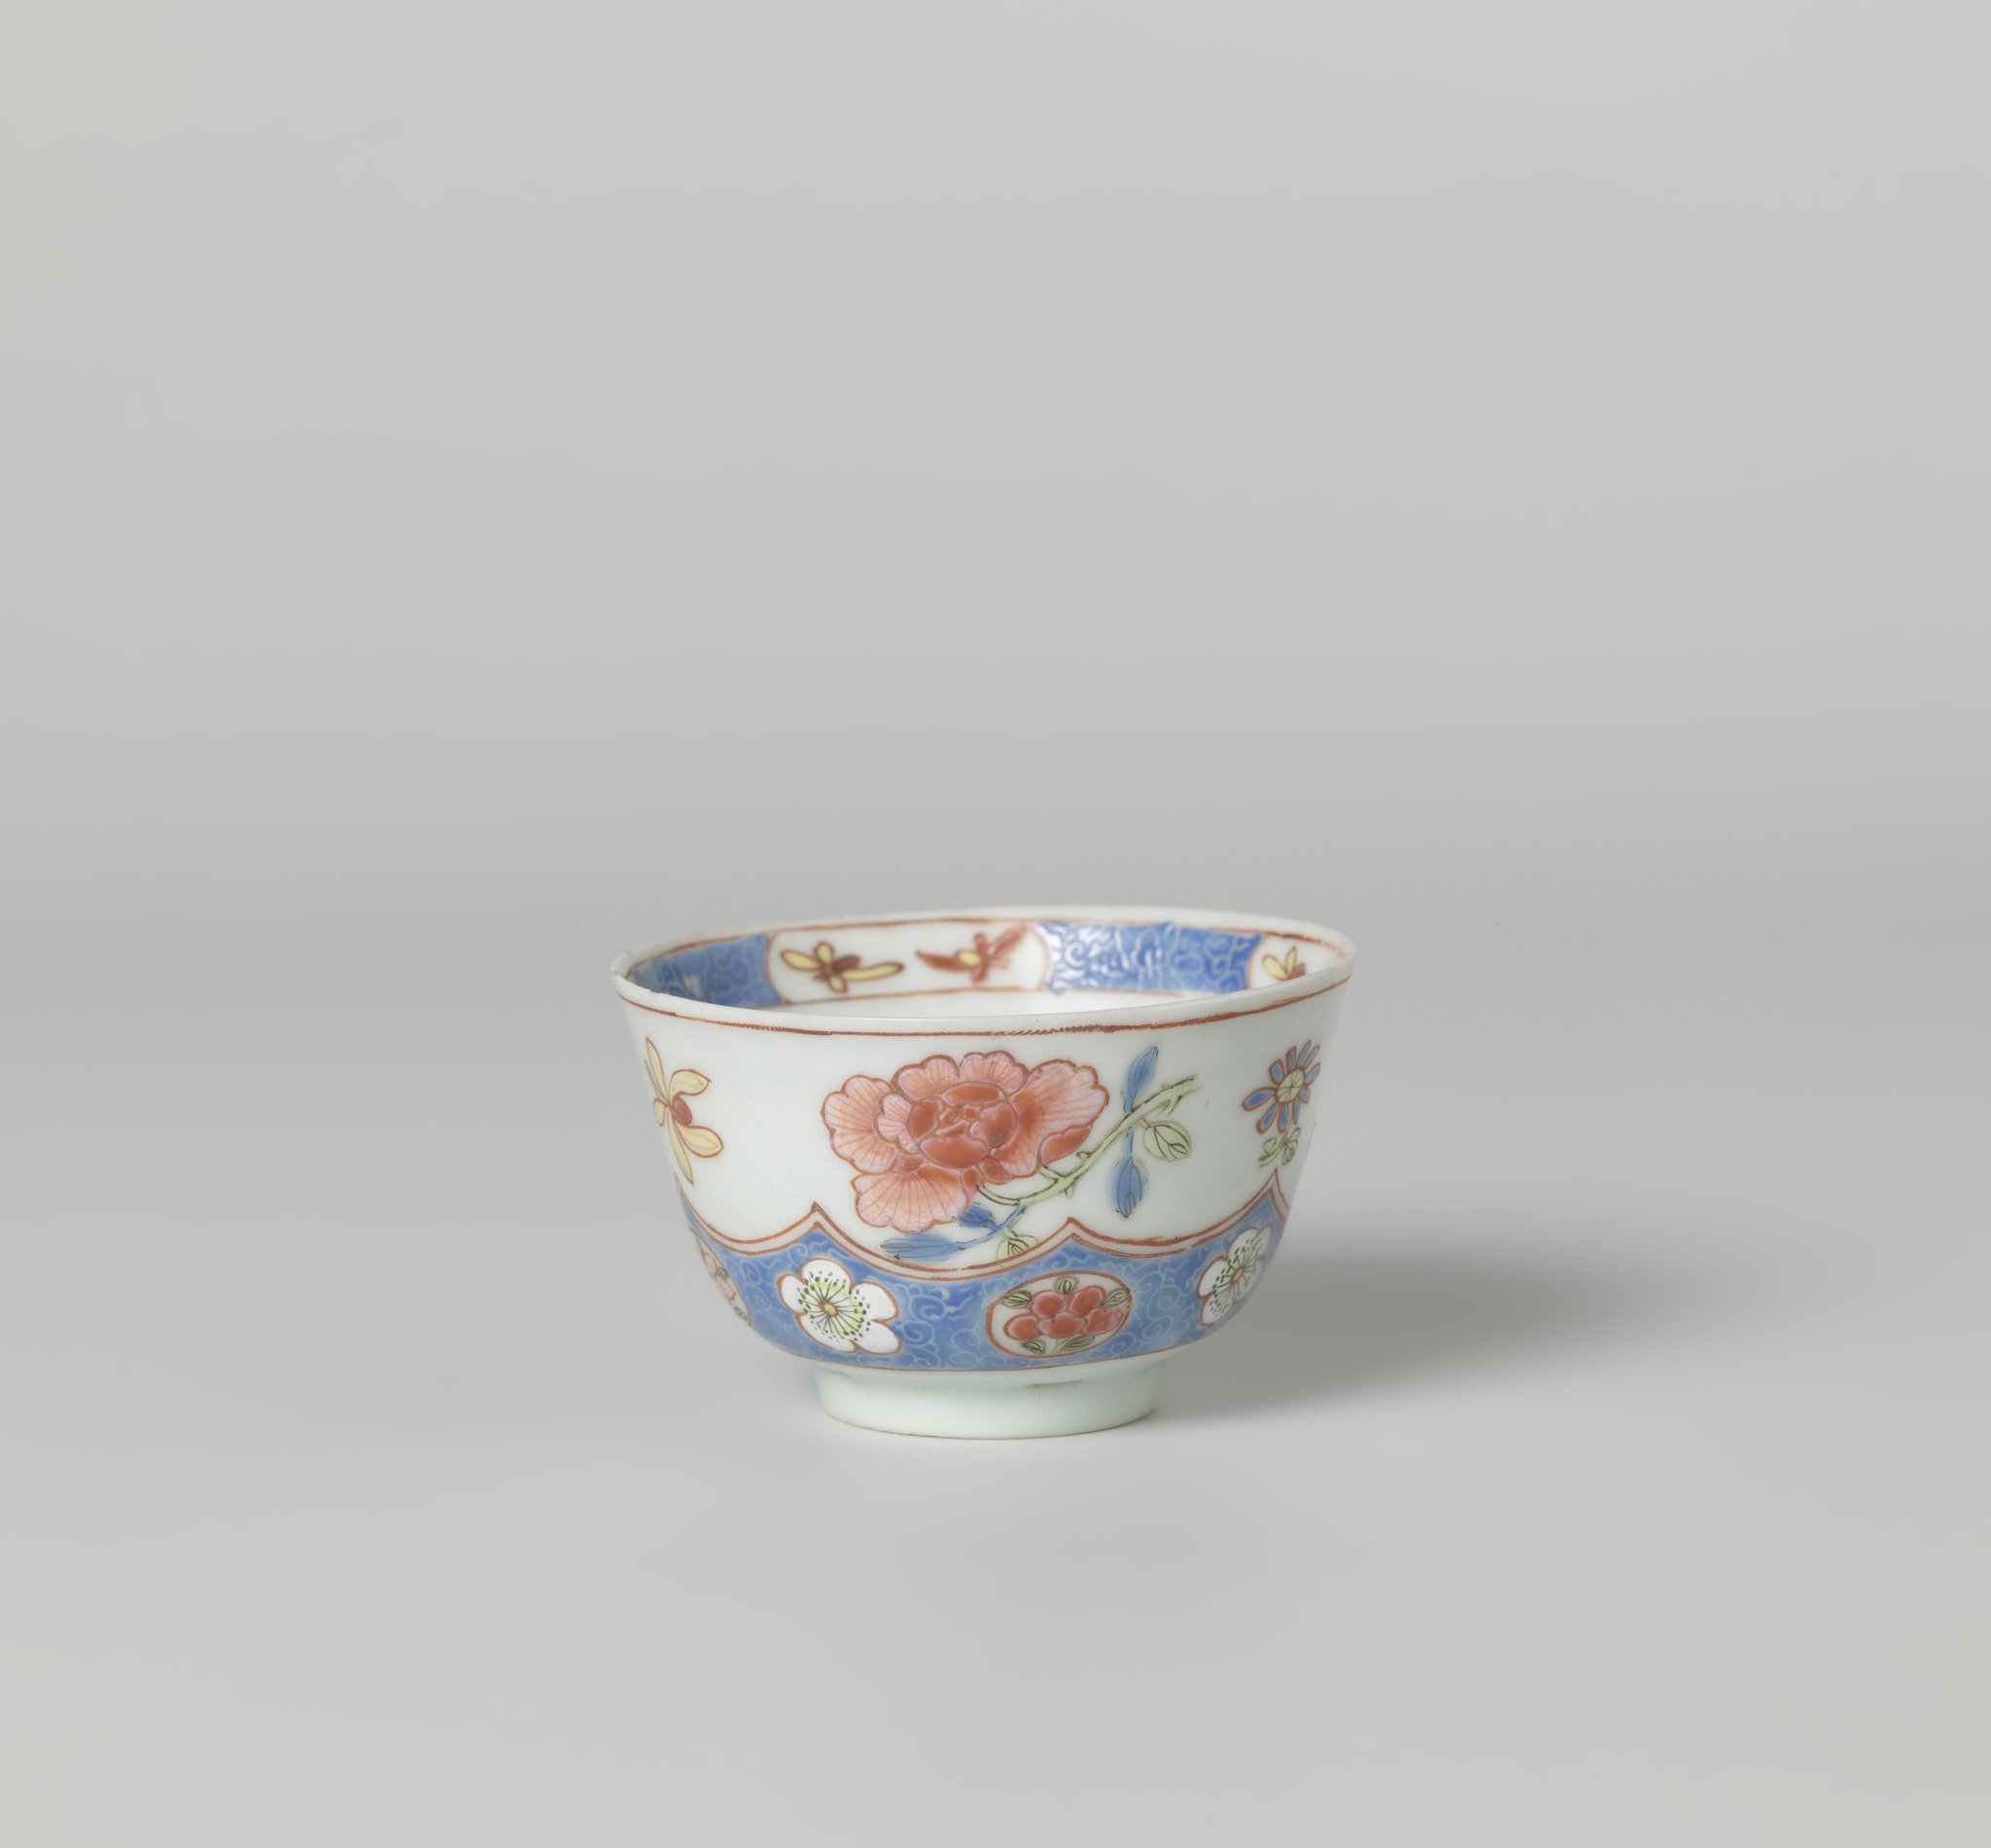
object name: cup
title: Cup with incised lotus scrolls and flowersprays in cartouches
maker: Anonymous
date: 1800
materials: glaze, paint, porcelain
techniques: firing, turning, vitrification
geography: china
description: Kop van porselein met rechte wand, beschilderd op het glazuur in blauw, rood, roze, groen, geel en zwart. Een gelobd cartouche met bloemtakken (o.a. pioen, chrysant, aster, orchidee) afgebeeld; op de wand blauw email met ingegrifte lotusranken, hierin uitgespaard bloemen en medaillons met bloemtakken. Famille rose.